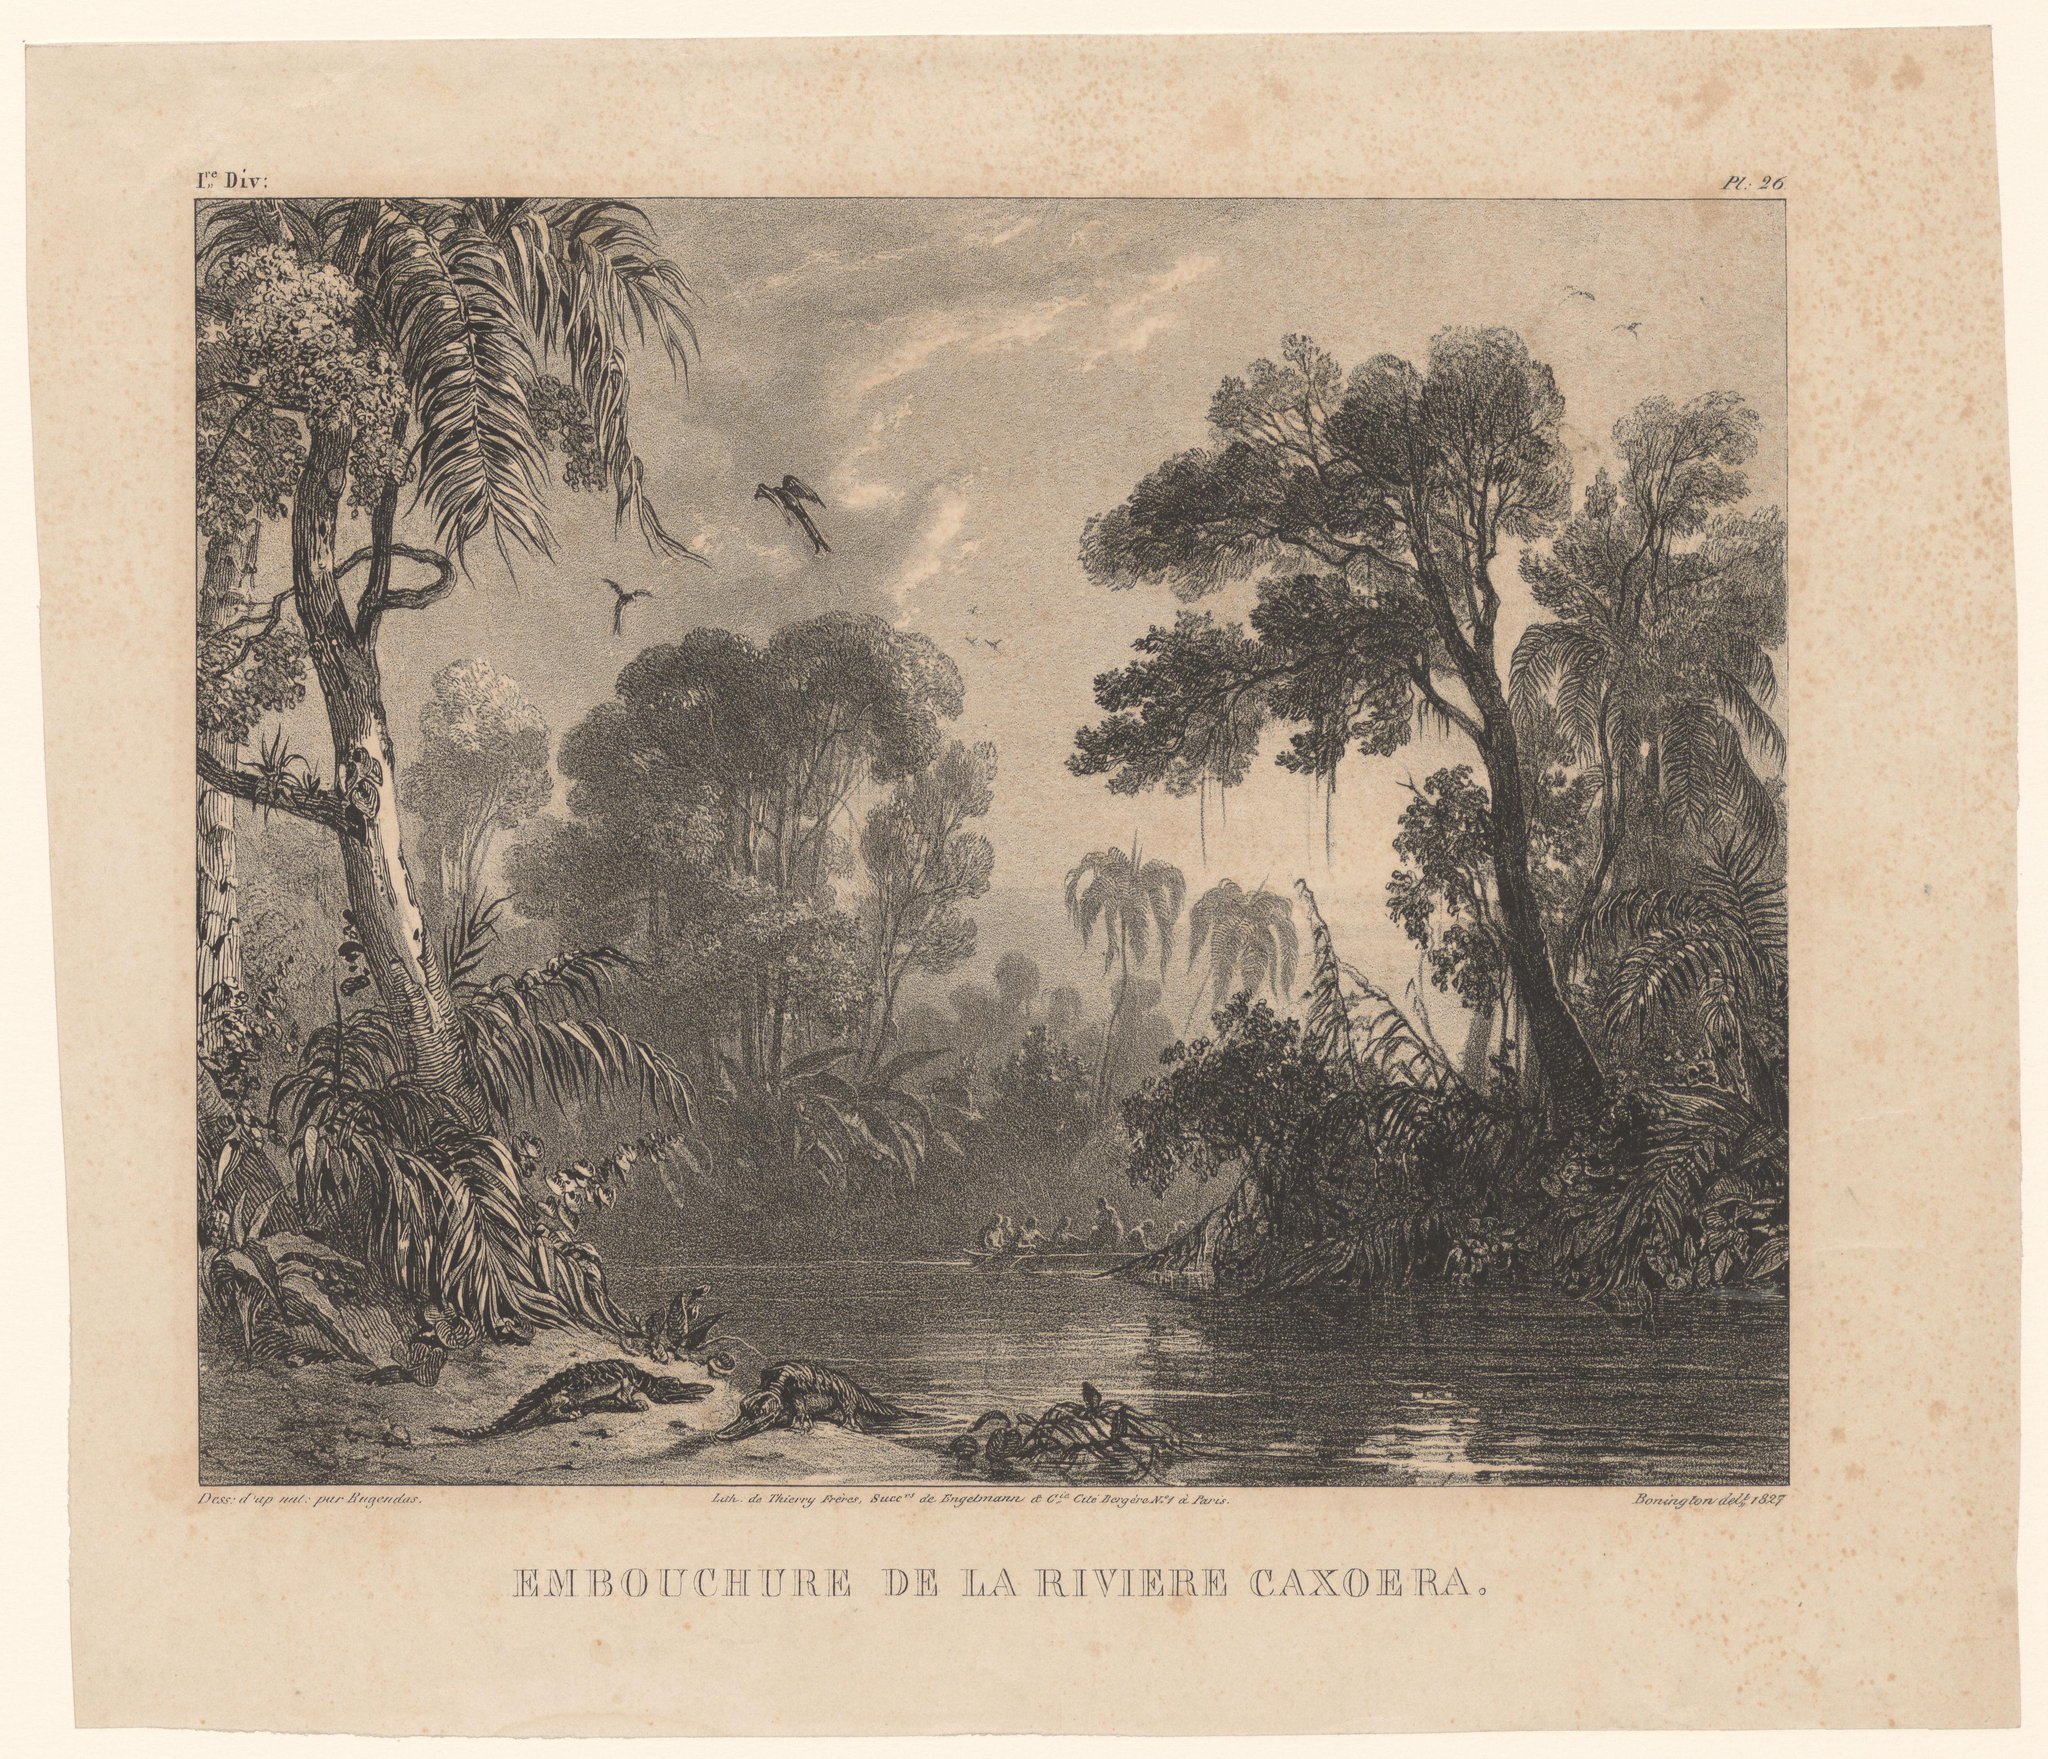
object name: print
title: Embouchure de la Riviere Caxoera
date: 1827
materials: paper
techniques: lithograph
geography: paris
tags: crocodiles, river, rowing-boat, canoe, etc., brasil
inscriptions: collector's mark: Lugt 2166, collector's mark: Lugt 2760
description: Deze prent behoort tot de serie 'Voyage pittoresque dans le Brésil'. Deze serie bestaat uit ongeveer honderd lithografieën vervaardigd door Victor Adam, Richard Parkes Bonington, A. Joly en anderen, gemaakt naar tekeningen van Moritz Rugendas tijdens een expeditie in Brazilië (1821-1825). De serie is tussen 1827 en 1835 in Parijs uitgegeven door Engelmann.